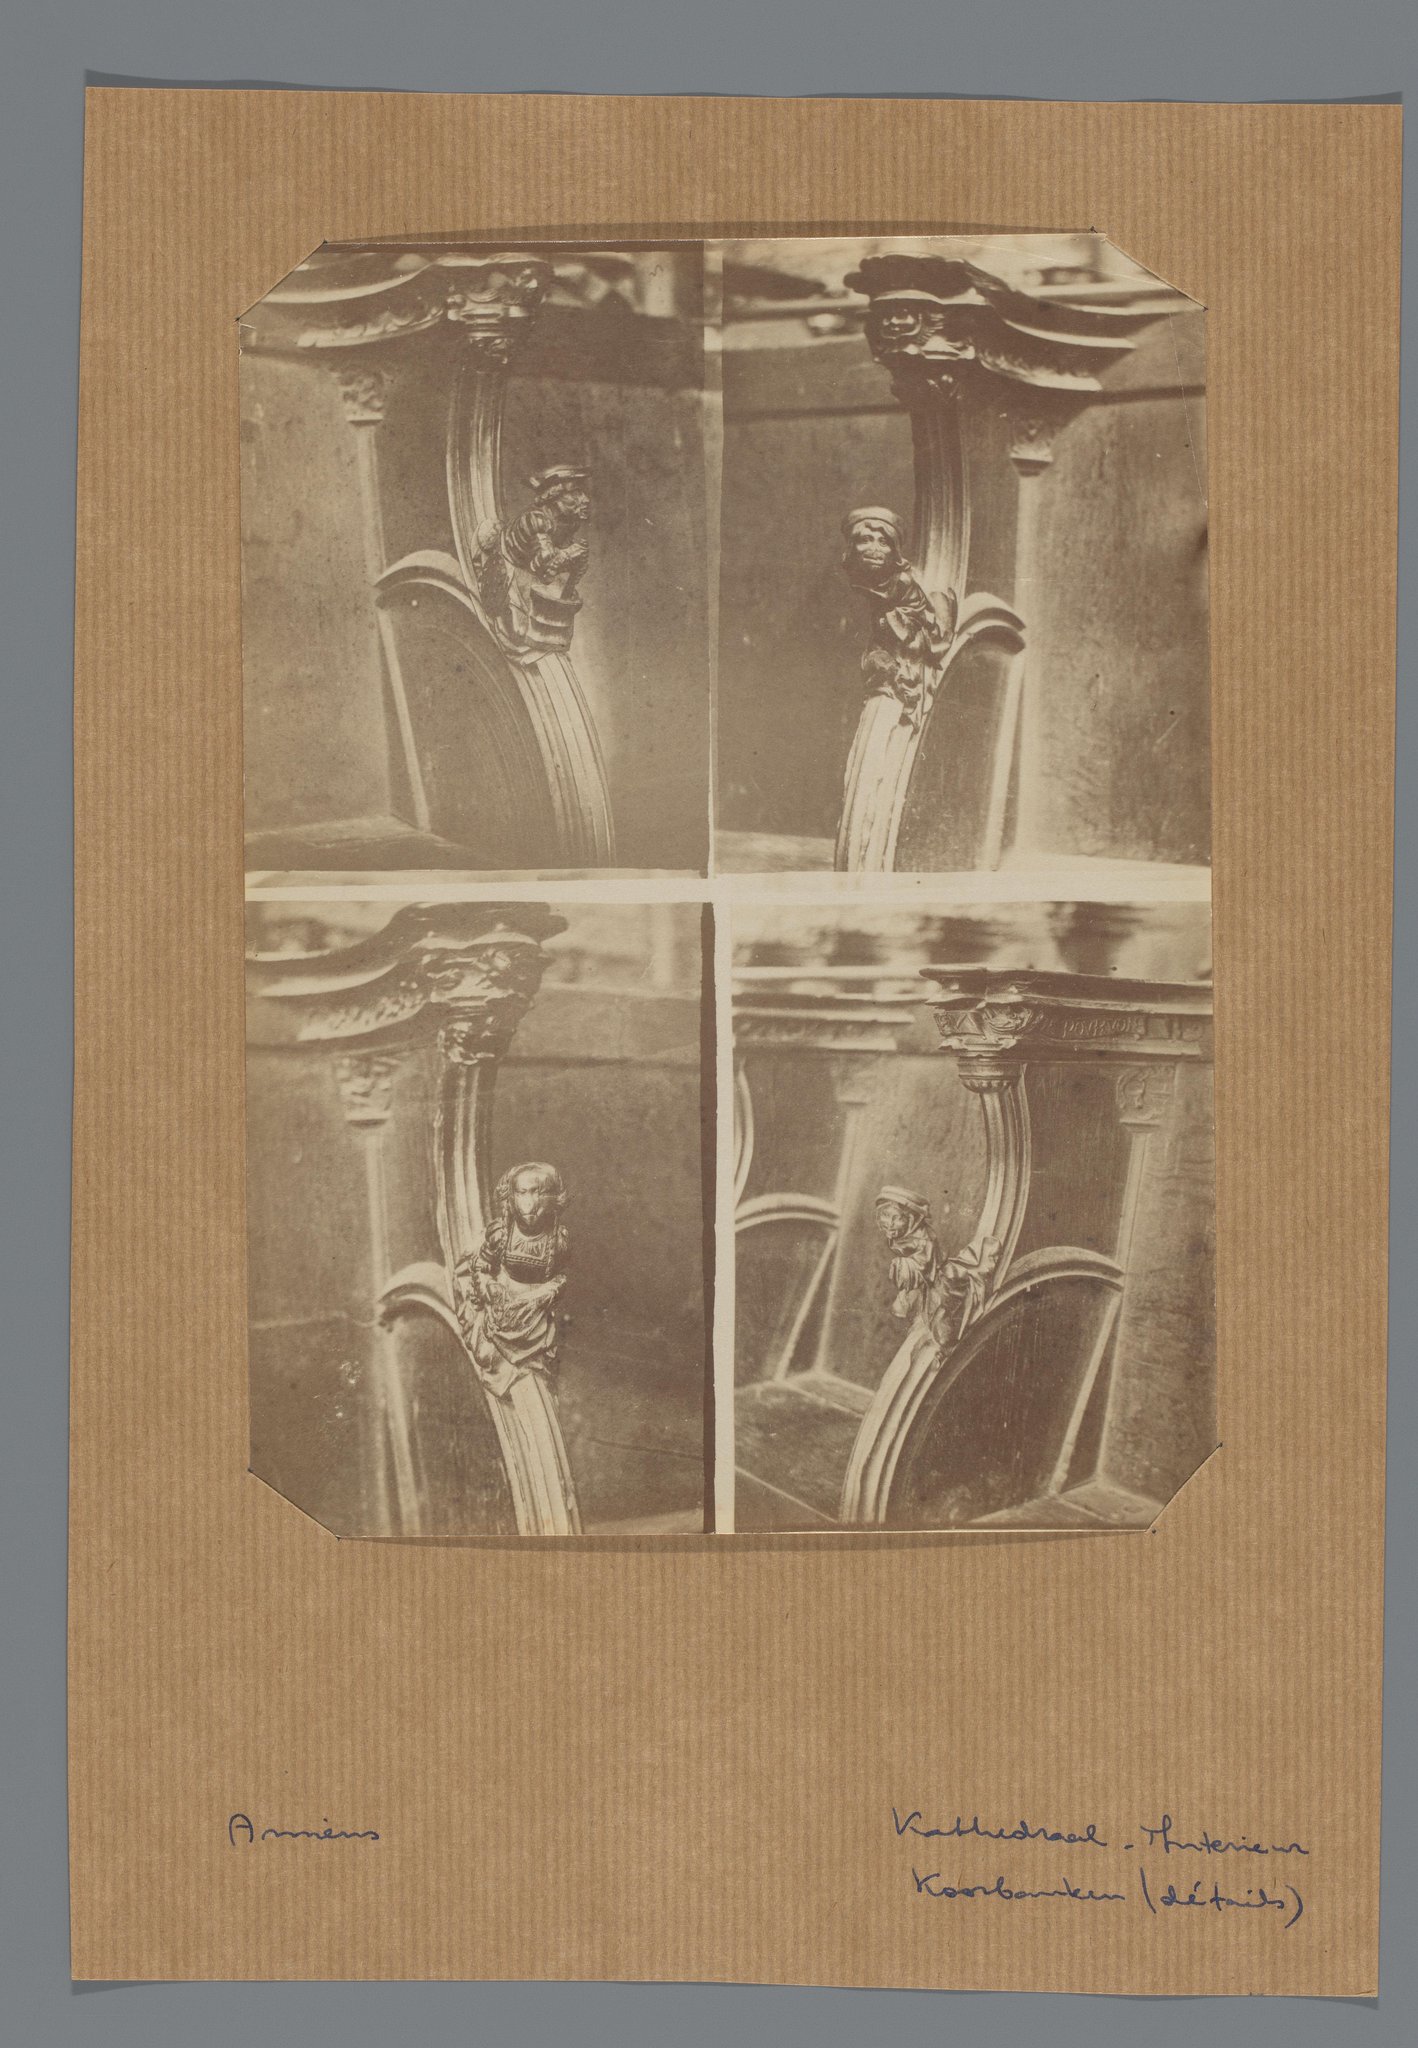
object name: photograph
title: Amiens. Cathedrail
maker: Anonymous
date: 1850-1880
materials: photographic support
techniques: albumen print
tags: notre-dame d'amiens